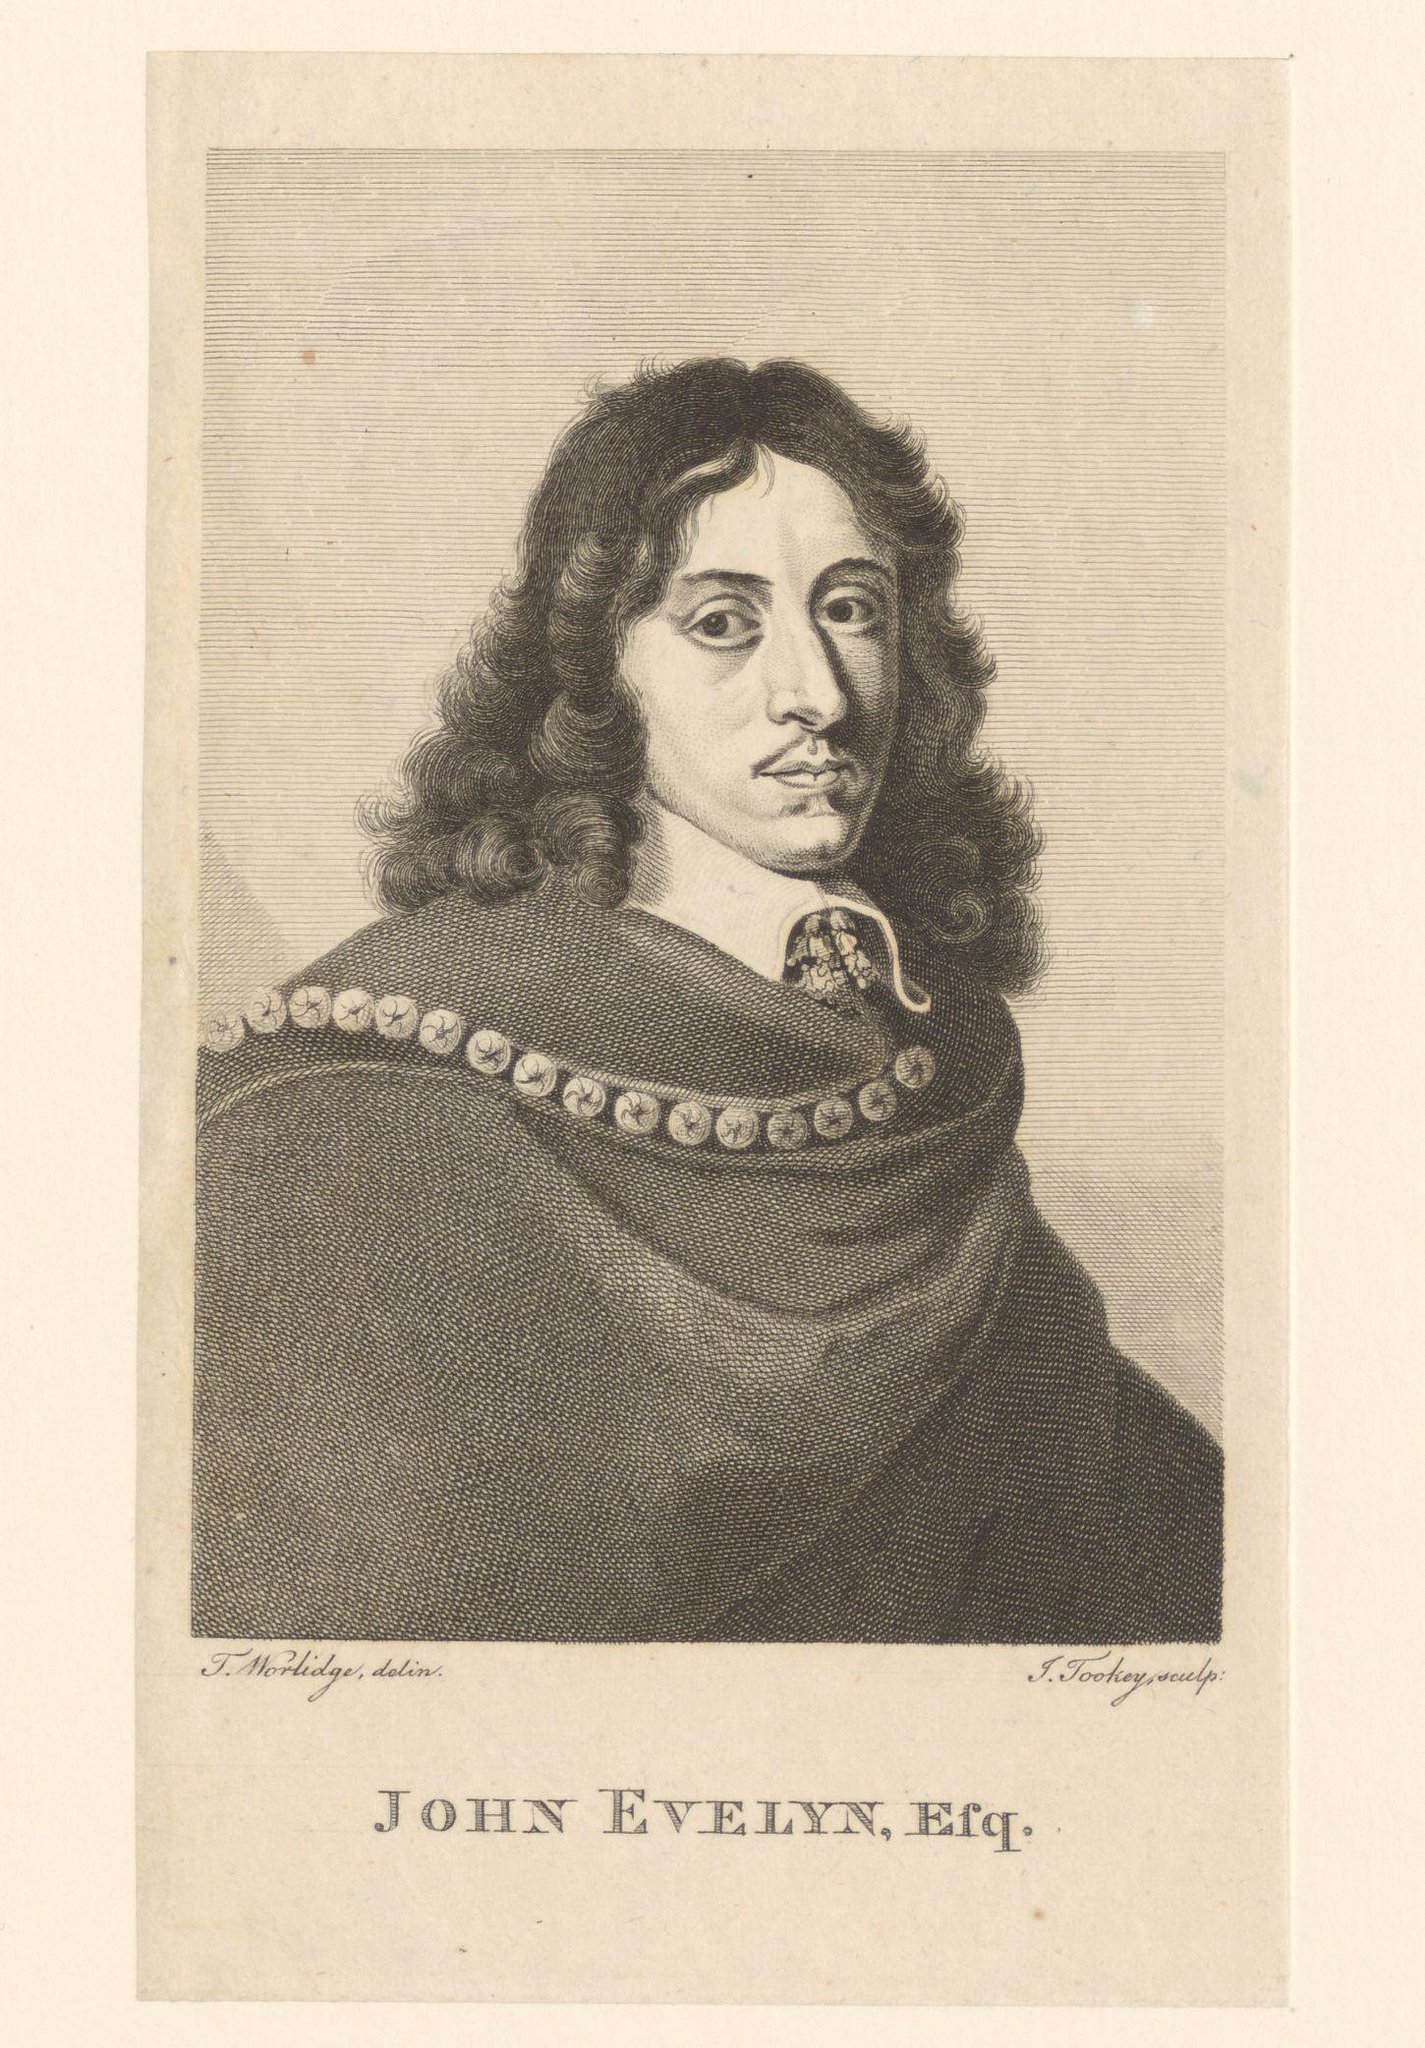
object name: print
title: Portret van John Evelyn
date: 1800-1830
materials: paper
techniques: etching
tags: print maker, john evelyn, historical persons, portrait of a writer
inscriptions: collector's mark: Lugt 2228